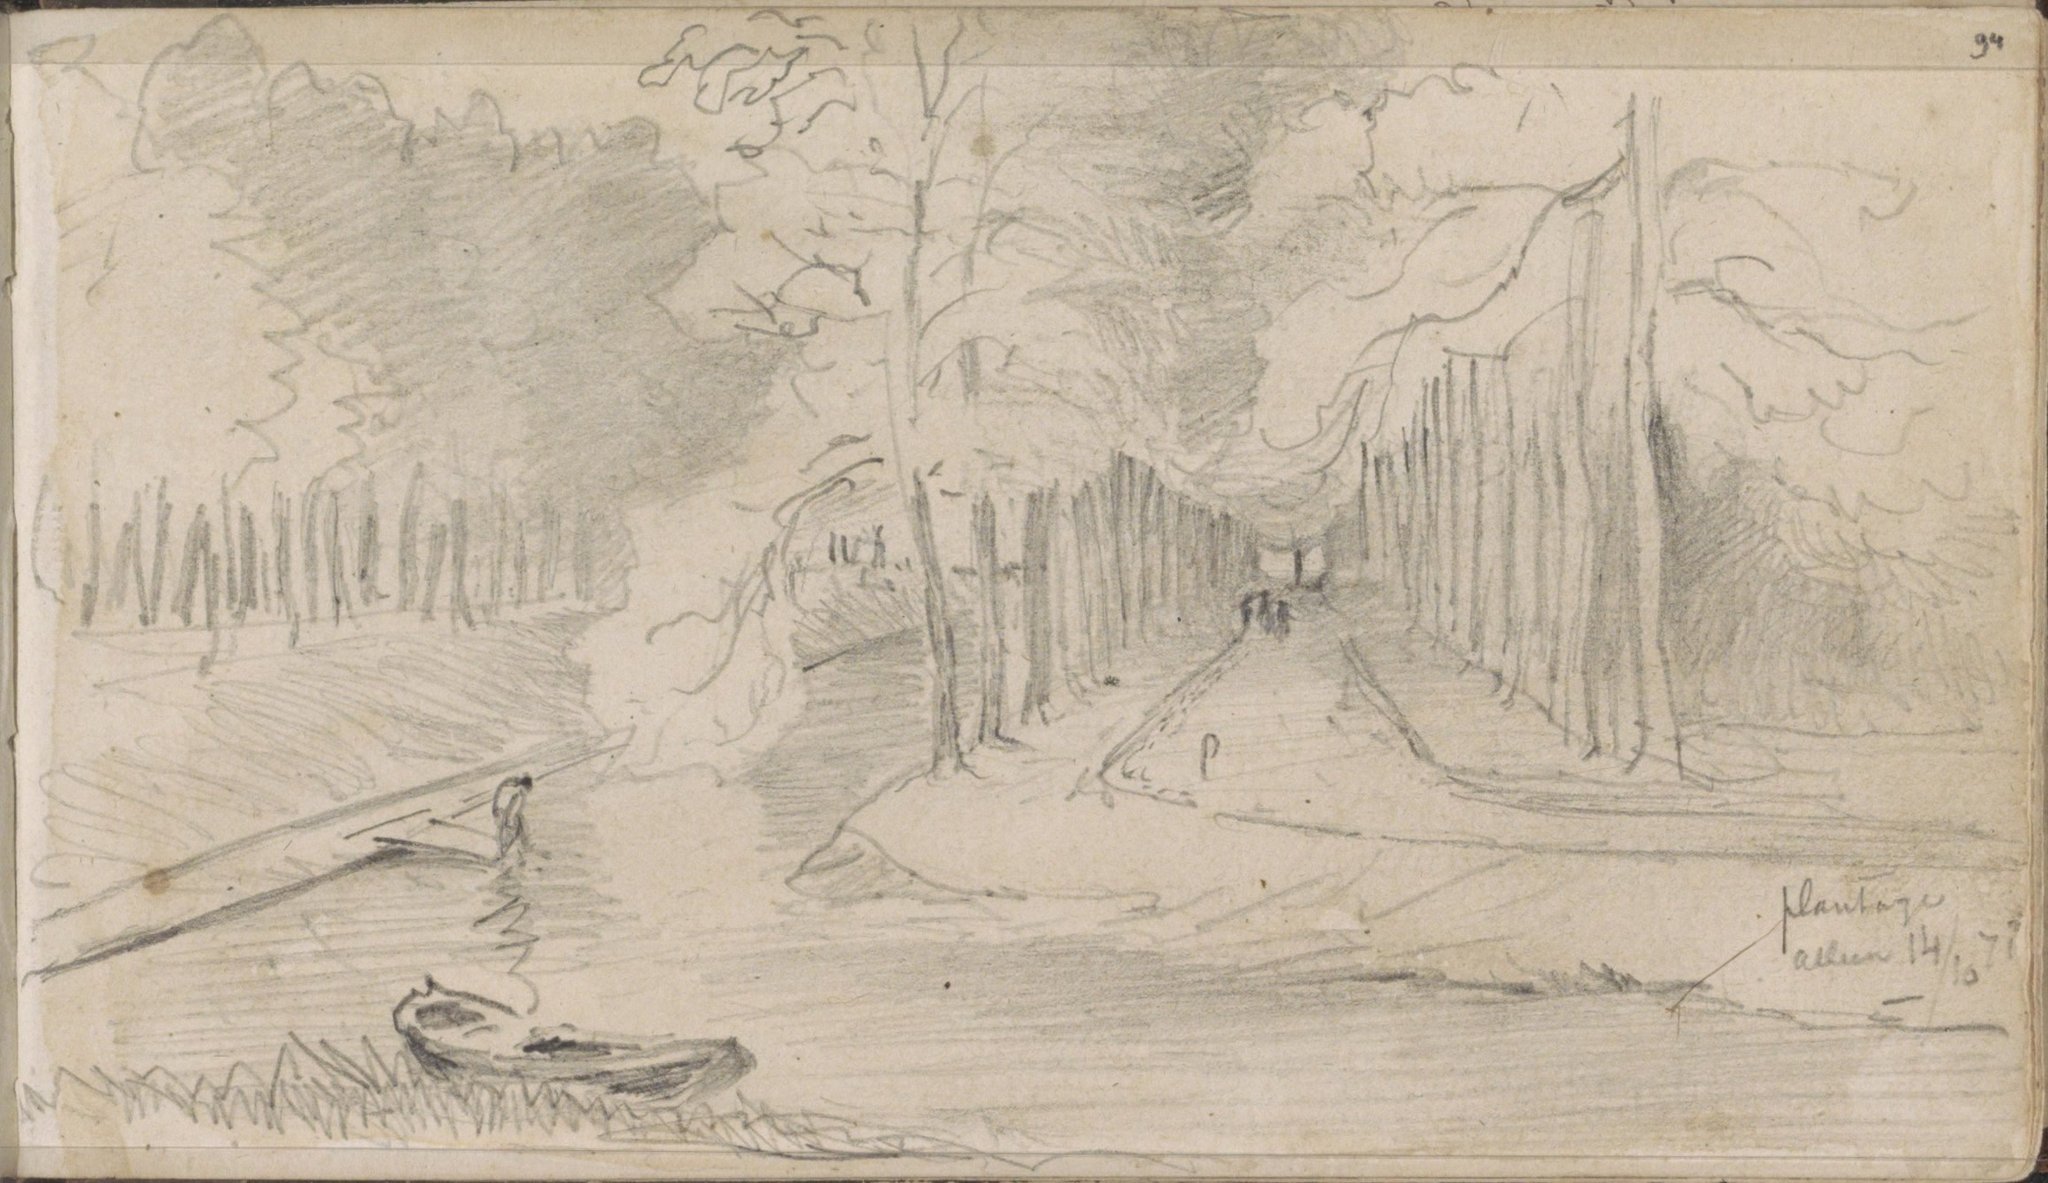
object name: sketchbook leaf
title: Bospad aan een kanaal bij de Plantage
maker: johannes tavenraat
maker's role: draughtsman, painter, print maker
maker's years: 1809-1881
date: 1810-1871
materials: ink, paper, pencil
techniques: brush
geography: rotterdam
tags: canal, forest path or lane, landscapes (+ landscape with figures, staffage), rotterdam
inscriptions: date and inscription: ‘plantage/ alleen 14/10 71’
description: Blad 94 recto uit een schetsboek met 98 bladen.